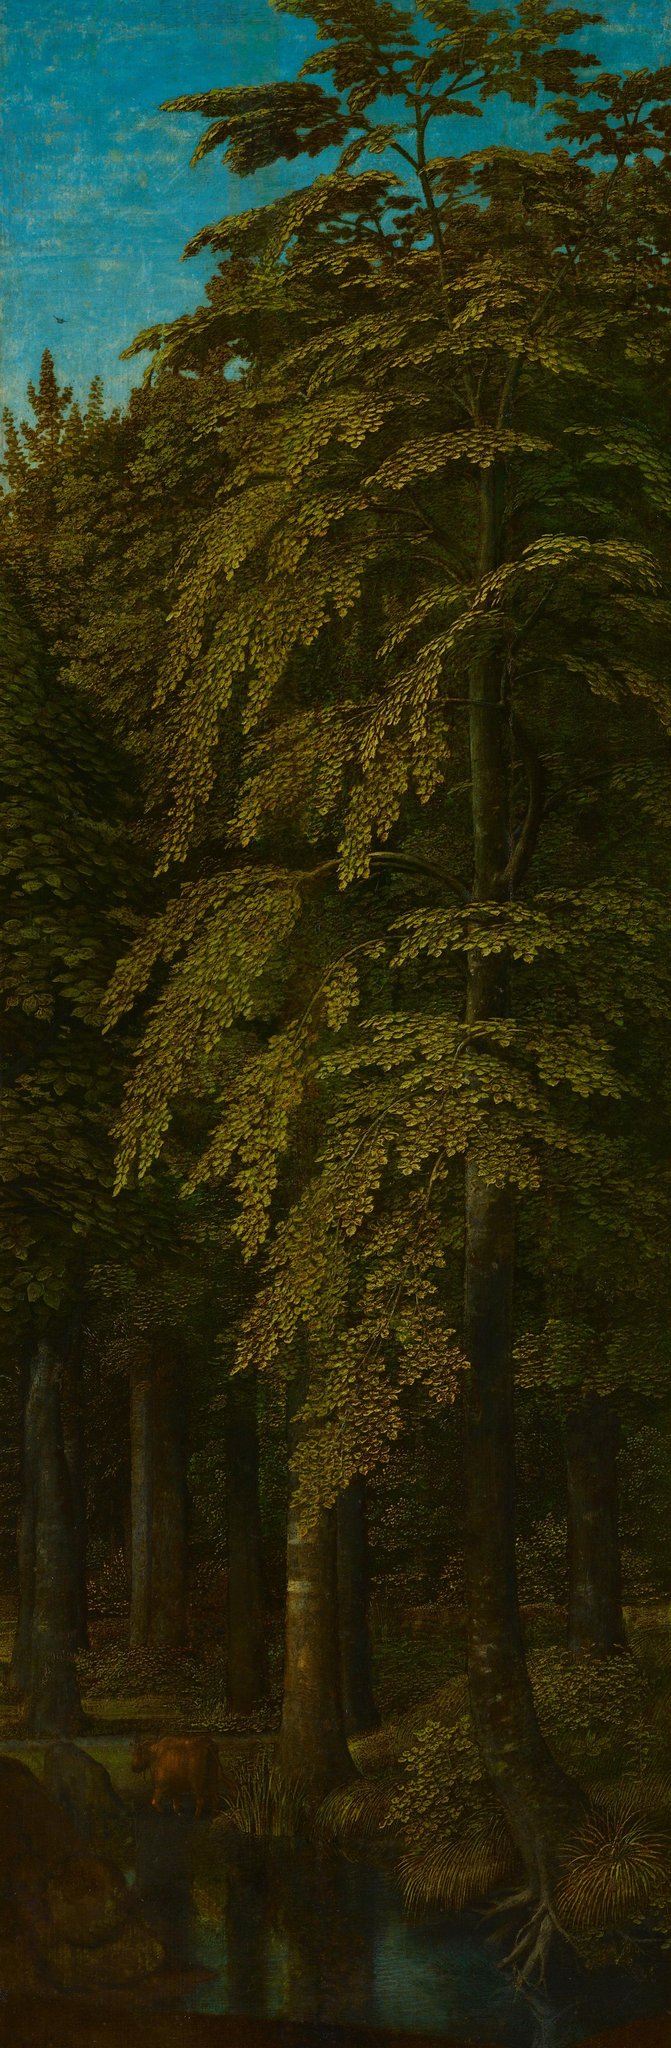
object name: painting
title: View in a Forest, outer right wing of a triptych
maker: gerard david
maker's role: draughtsman, painter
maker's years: 1460-1523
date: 1505-1515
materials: oil, panel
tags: forest, wood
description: Bosgezicht. Eén van de twee bosgezichten op de buitenzijde van de twee zijpanelen van een drieluik (zie ook SK-A-3134). Het betreft hier het rechterzijpaneel met een os en een ezel bij het water. De binnenzijden van deze zijpanelen en het middenpaneel (met een aanbidding van het kind) bevinden zich in het Metropolitan Musuem of Art in New York.